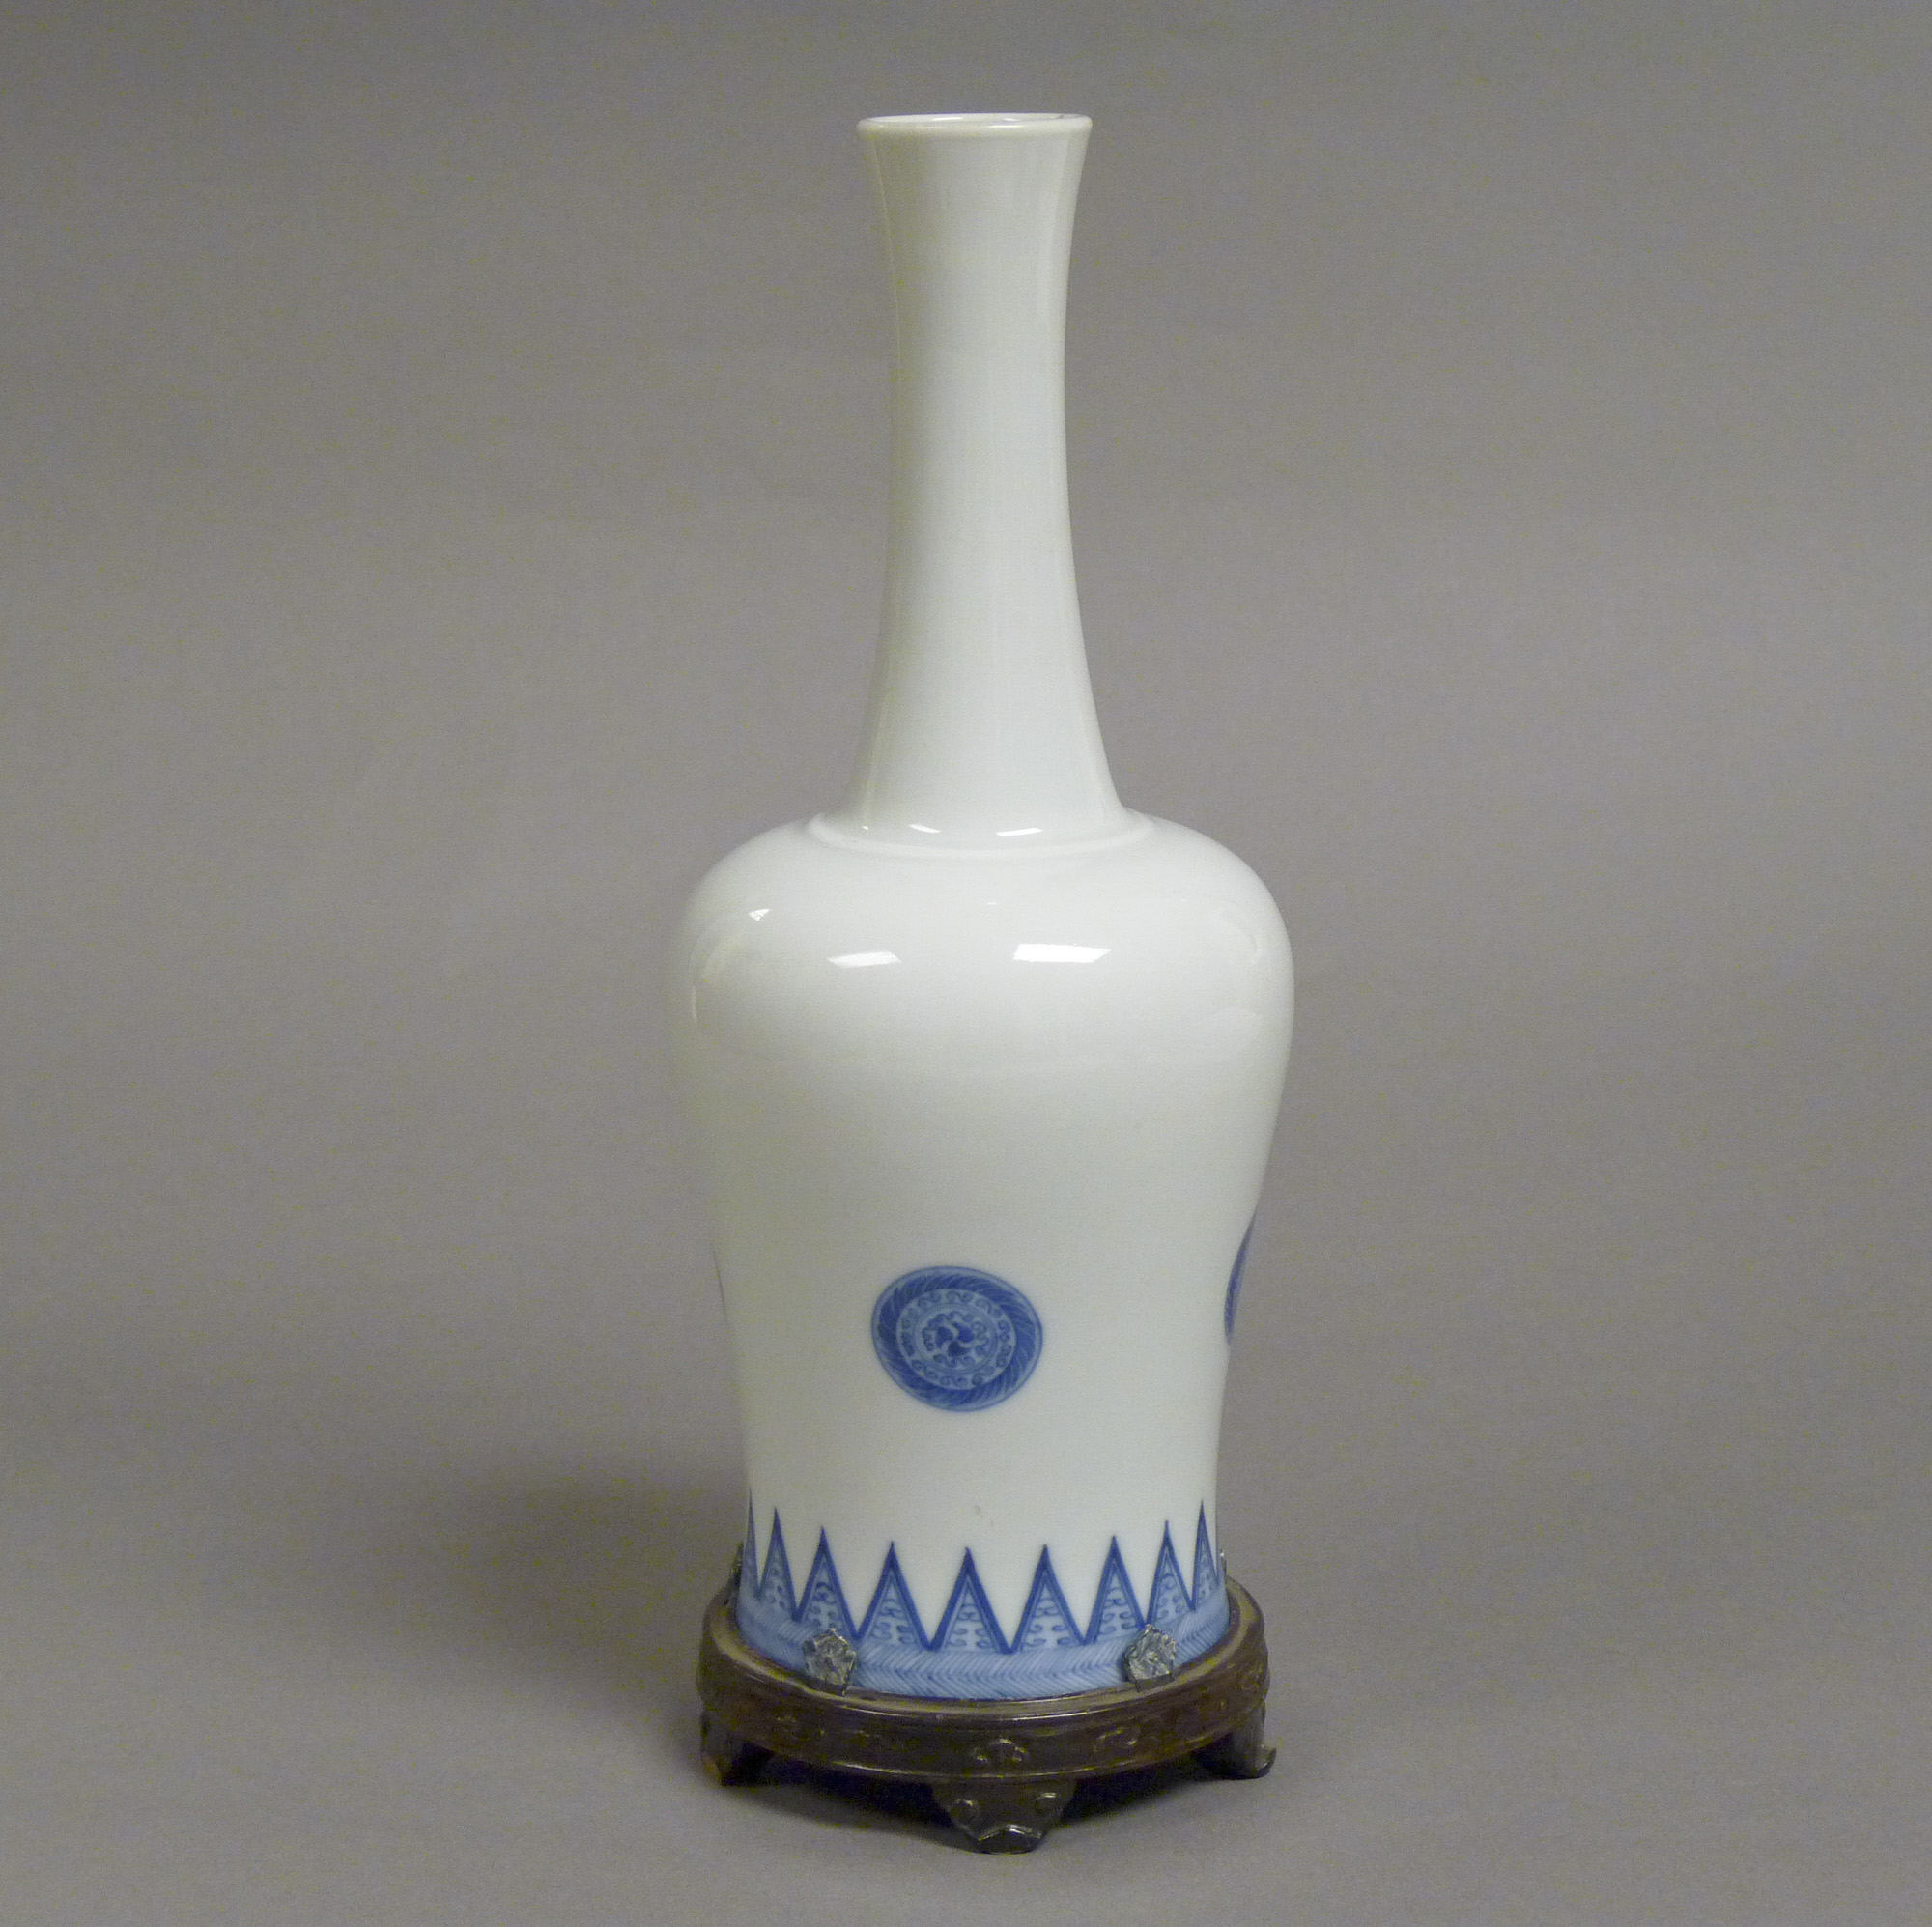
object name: bottle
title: Bottle (one of a pair)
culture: chinese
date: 1700-1722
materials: porcelain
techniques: painting, underglaze